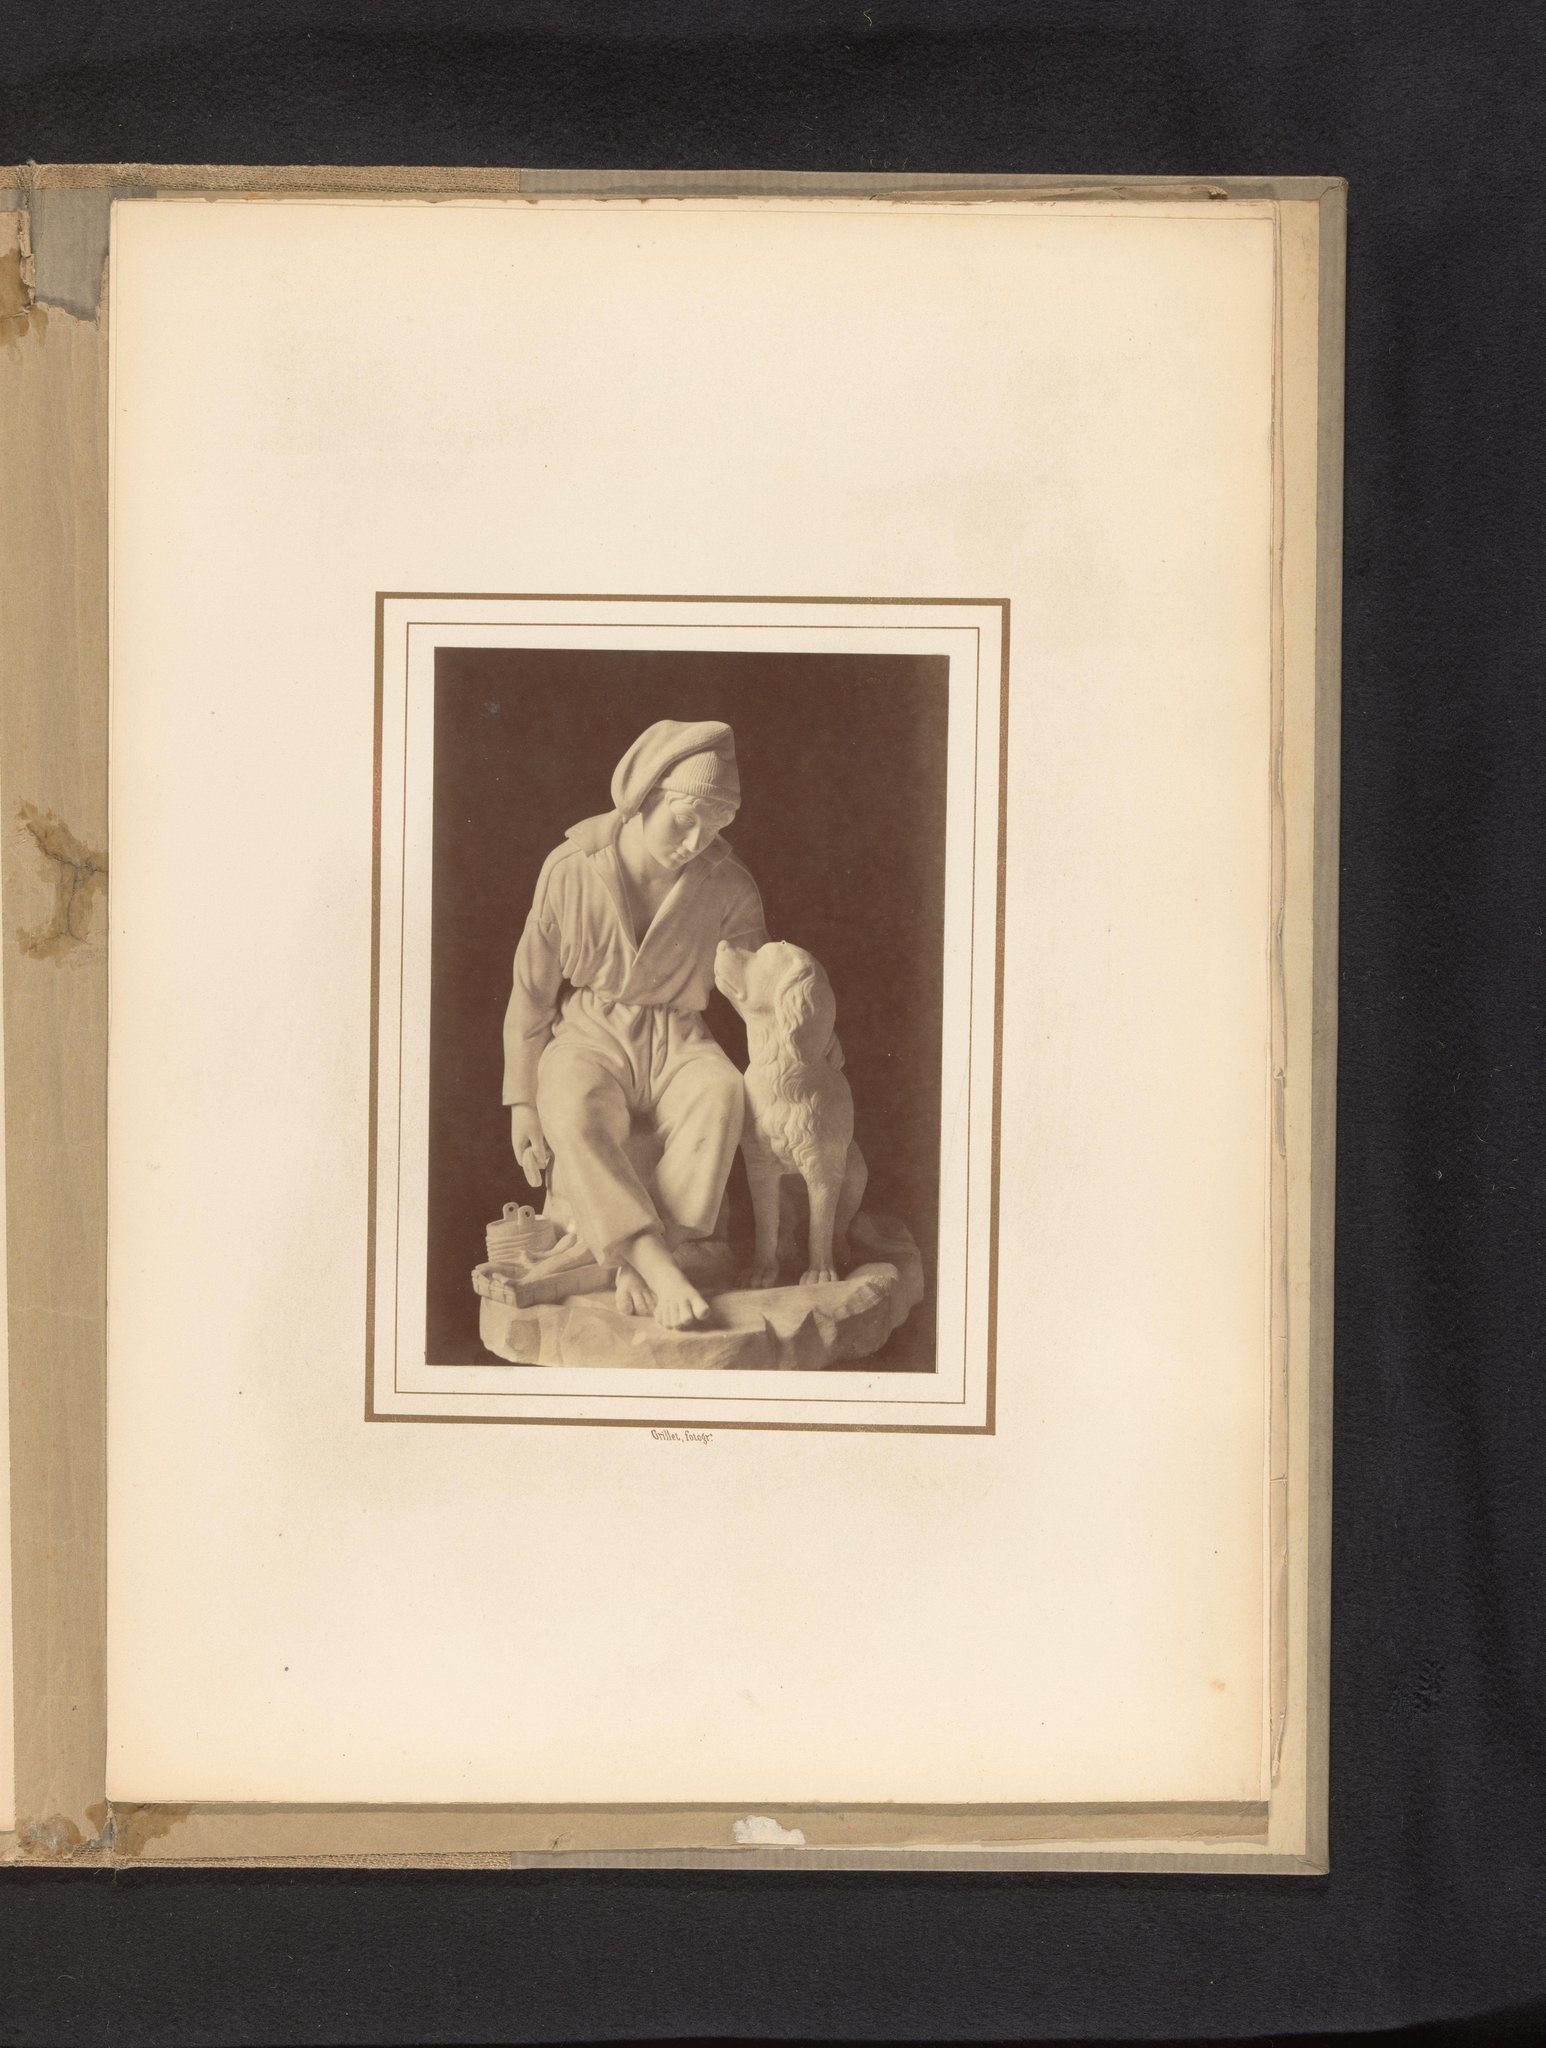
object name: photograph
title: Sculptuur van een jongen en een hond door Leopold Borbone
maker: grillet jeune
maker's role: fotograaf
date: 1854-1859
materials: photographic support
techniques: albumen print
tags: boy (child between toddler and youth), piece of sculpture, reproduction of a piece of sculpture, dog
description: Deze foto maakt deel uit van een omslag met 18 foto's op 18 bladen en 14 tekstbladen.